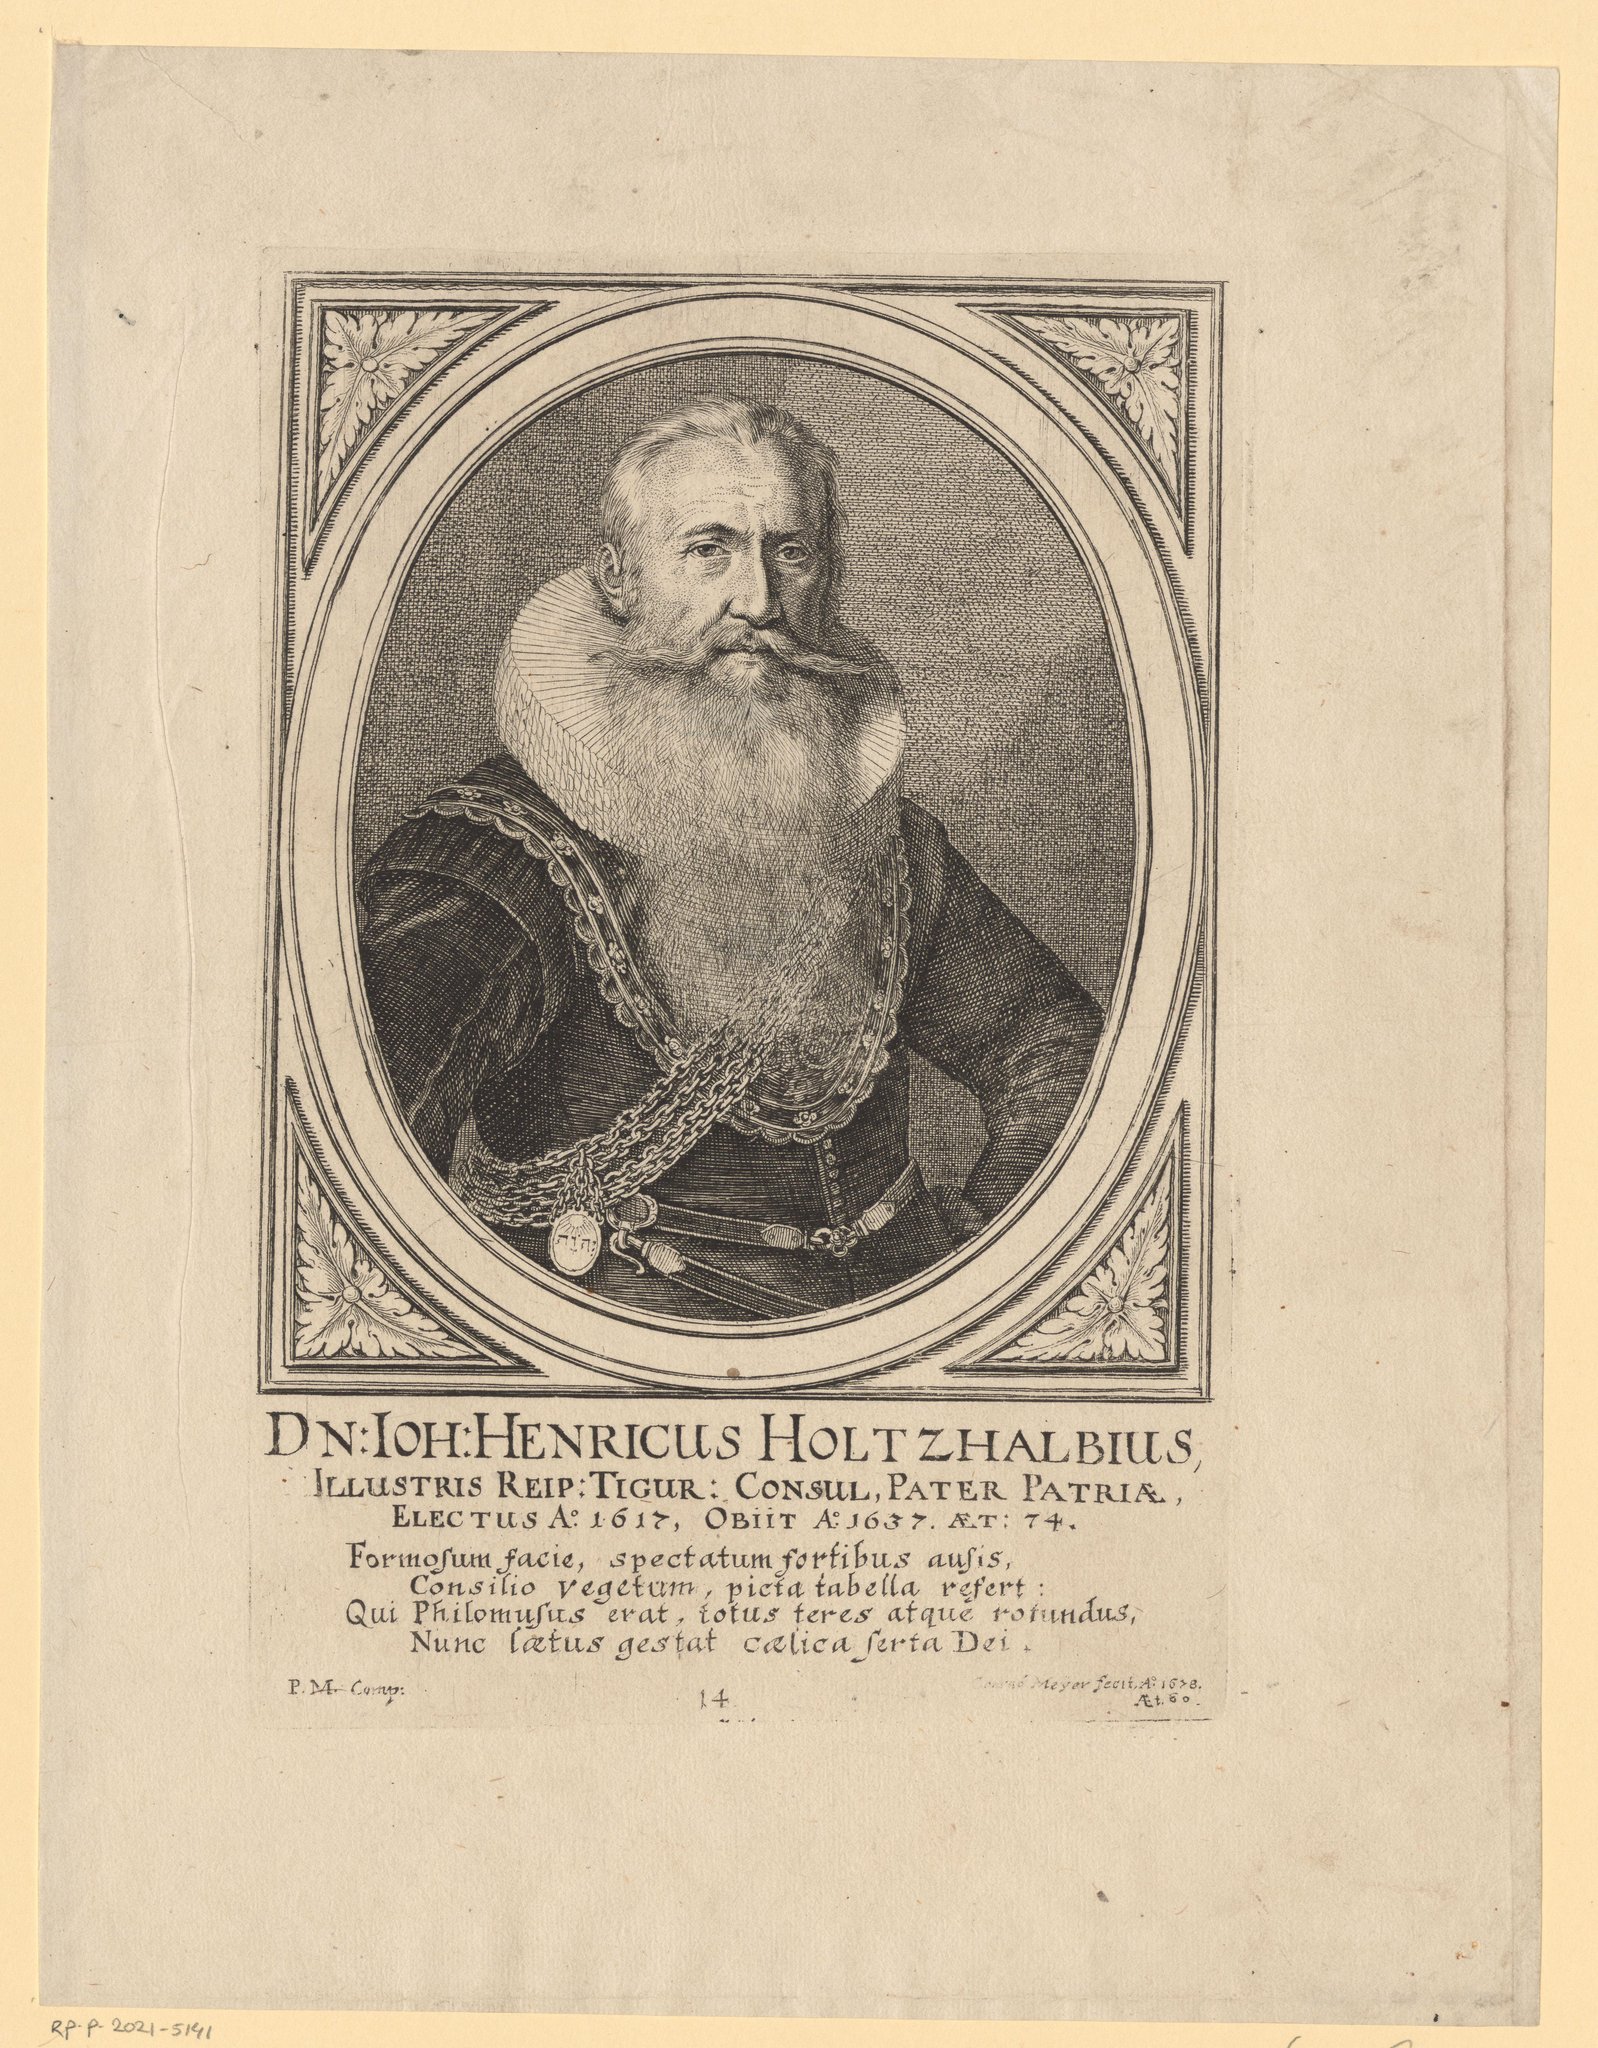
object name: print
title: Portretten van burgemeesters van Zürich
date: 1678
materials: paper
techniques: engraving, etching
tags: mayor, mayor, burgomaster, other non-personal regalia, e.g. mayor chain, historical persons, beard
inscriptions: collector's mark: Lugt 2228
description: Onderdeel van een serie van 67(?) portretten van burgemeesters van Zürich. Zie Hollstein German 110, 1-26.